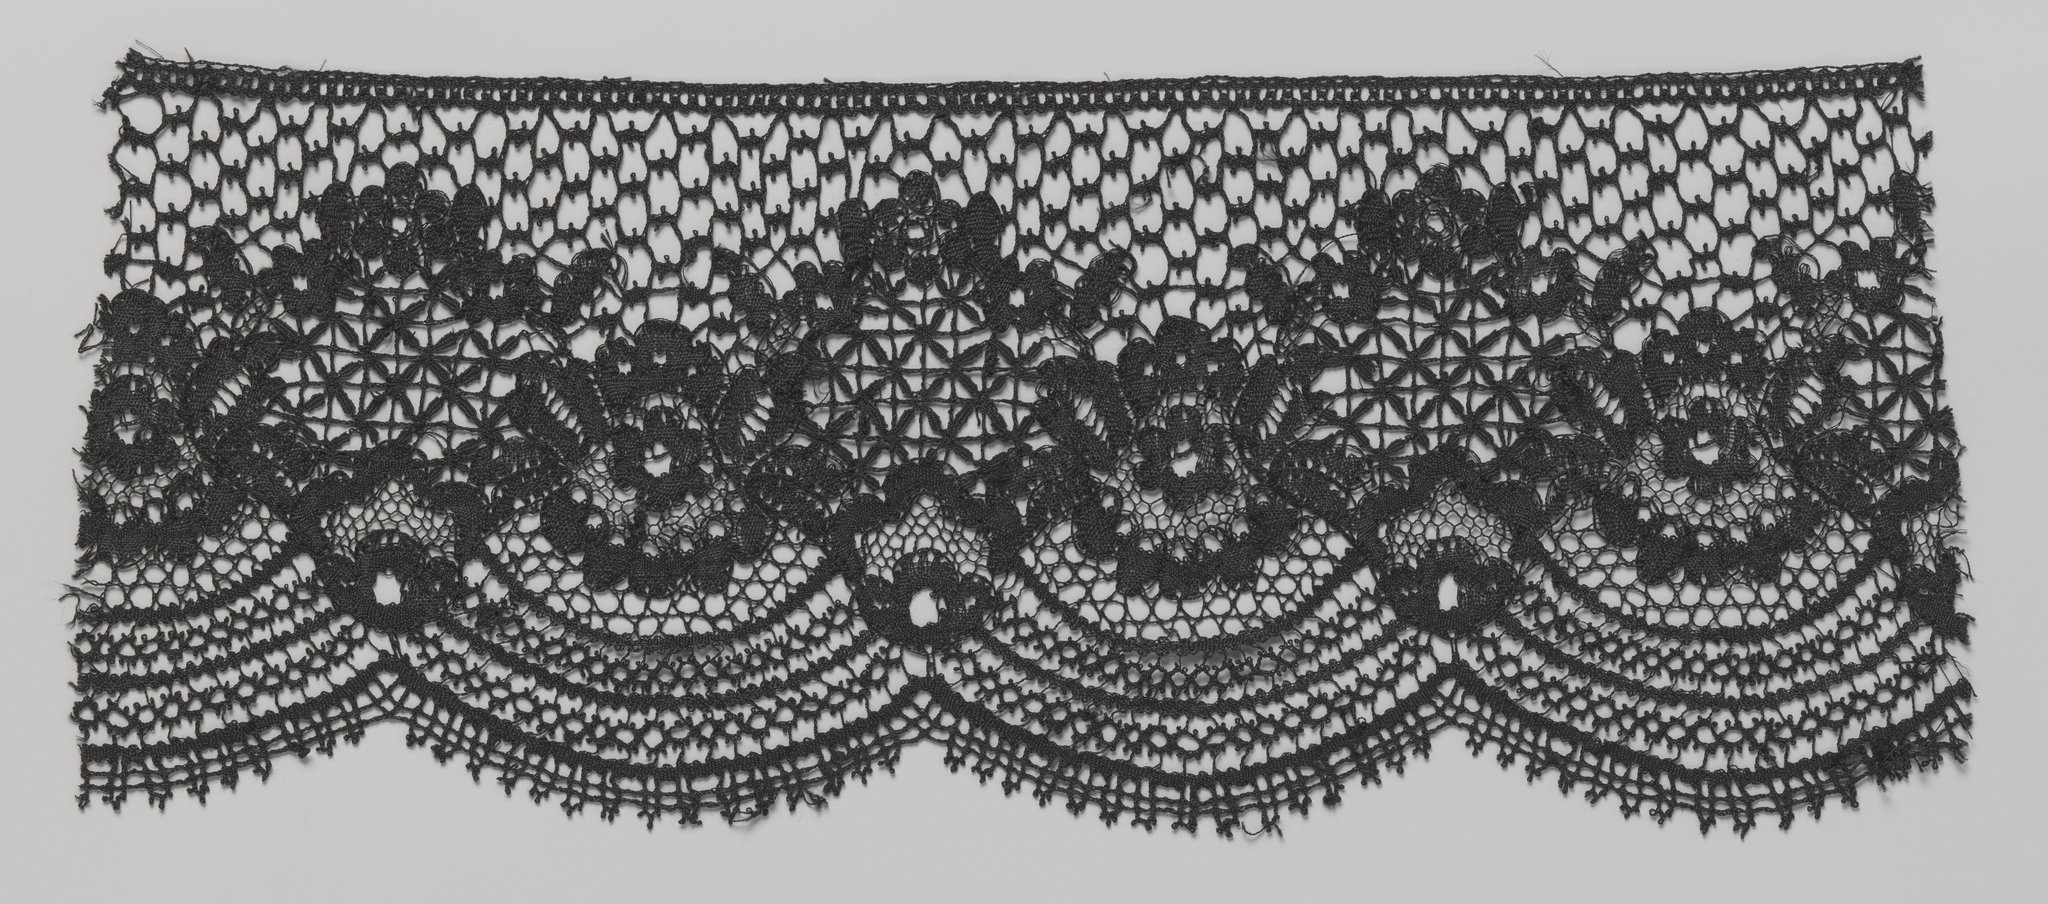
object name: strip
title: Strook kloskant met halfronde schulpen en rozetrozen tussen ruiten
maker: Anonymous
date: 1850-1874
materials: linen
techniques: lace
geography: le puy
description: Strook zwarte kloskant: Le Puy-kant. Het zich herhalende en symmetrische patroon bestaat uit een doorlopende brede sierband, die een schulpenrand met halfronde schulpen vormt. Op de schakelpunten tussen de schulpen staat een rozetbloem die wordt bekroond door een drielobbig motief. Een variatie op deze bloem met drielobbig motief komt terug in elke schulp. Boven de schakelpunten staat een min of meer ruitvormig veld met daarin een vierkant raster, met kruizen gemaakt in vormslag. Het ruit wordt bovenaan begrensd door drie rozetbloempjes met druppelvormige motiefjes ertussen. De motieven zijn gemaakt in linnenslag. Ze worden geaccentueerd door contourdraden en worden door verschillende siergronden met elkaar verbonden. De schulpenrand is afgewerkt met picots. De bovenzijde van de strook is recht afgewerkt.